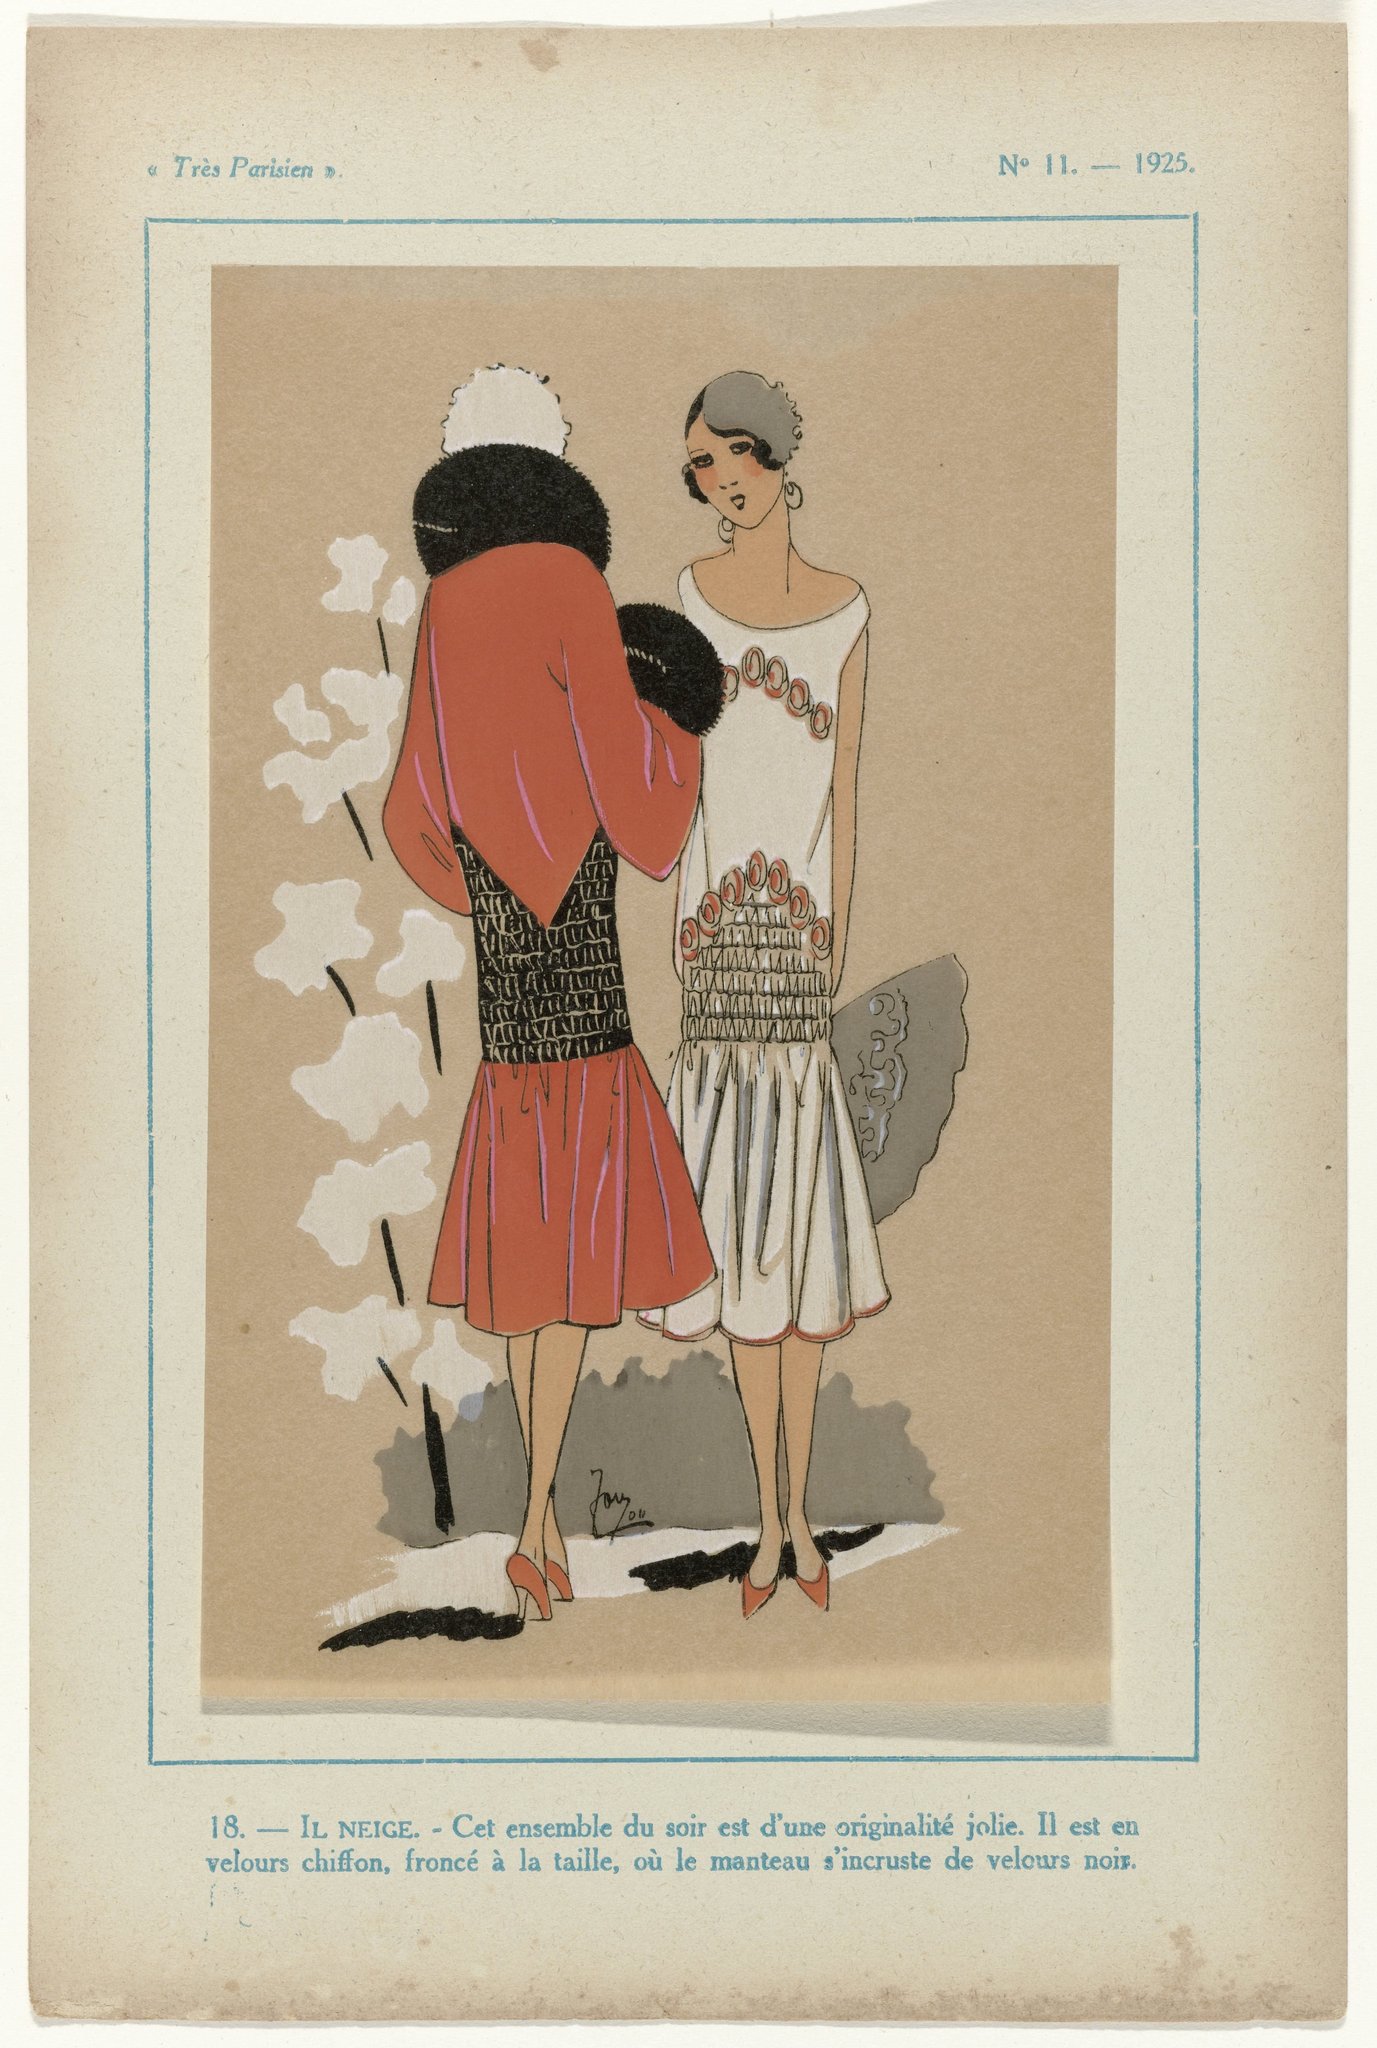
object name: fashion print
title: Très Parisien, 1925, No. 11, Pl. 18.- IL NEIGE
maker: g-p. joumard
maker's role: publisher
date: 1925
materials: paper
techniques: hand coloring, letterpress printing, lithography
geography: paris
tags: ear-rings (+ women's clothes), dress, gown: evening dress (+ women's clothes), coat (evening coat) (+ women's clothes), fashion plates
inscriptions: caption: ‘18. - IL NEIGE. - Cet ensemble du soir est d'une originalité jolie. Il est en velours chiffon, froncé à la taille, où le manteau s'incruste de velours noir.’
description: Ensemble (japon en mantel) voor de avond van 'velours chiffon'. Prent uit het modetijdschrift Très Parisien...La Mode, Le Chic, L'Élégance (1920-1936)